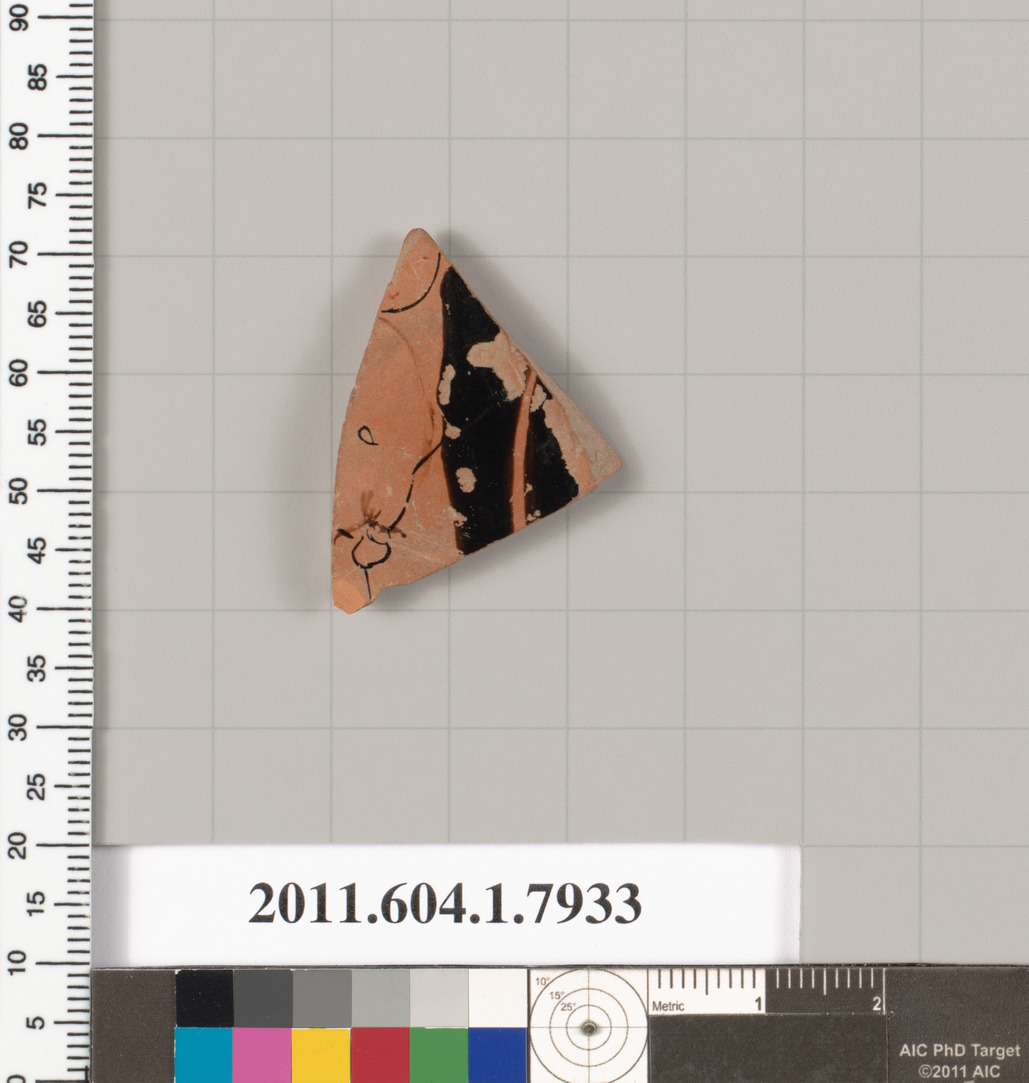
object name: kylix fragment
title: Terracotta fragment of a kylix (drinking cup)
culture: greek, attic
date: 460-450 BCE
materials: terracotta